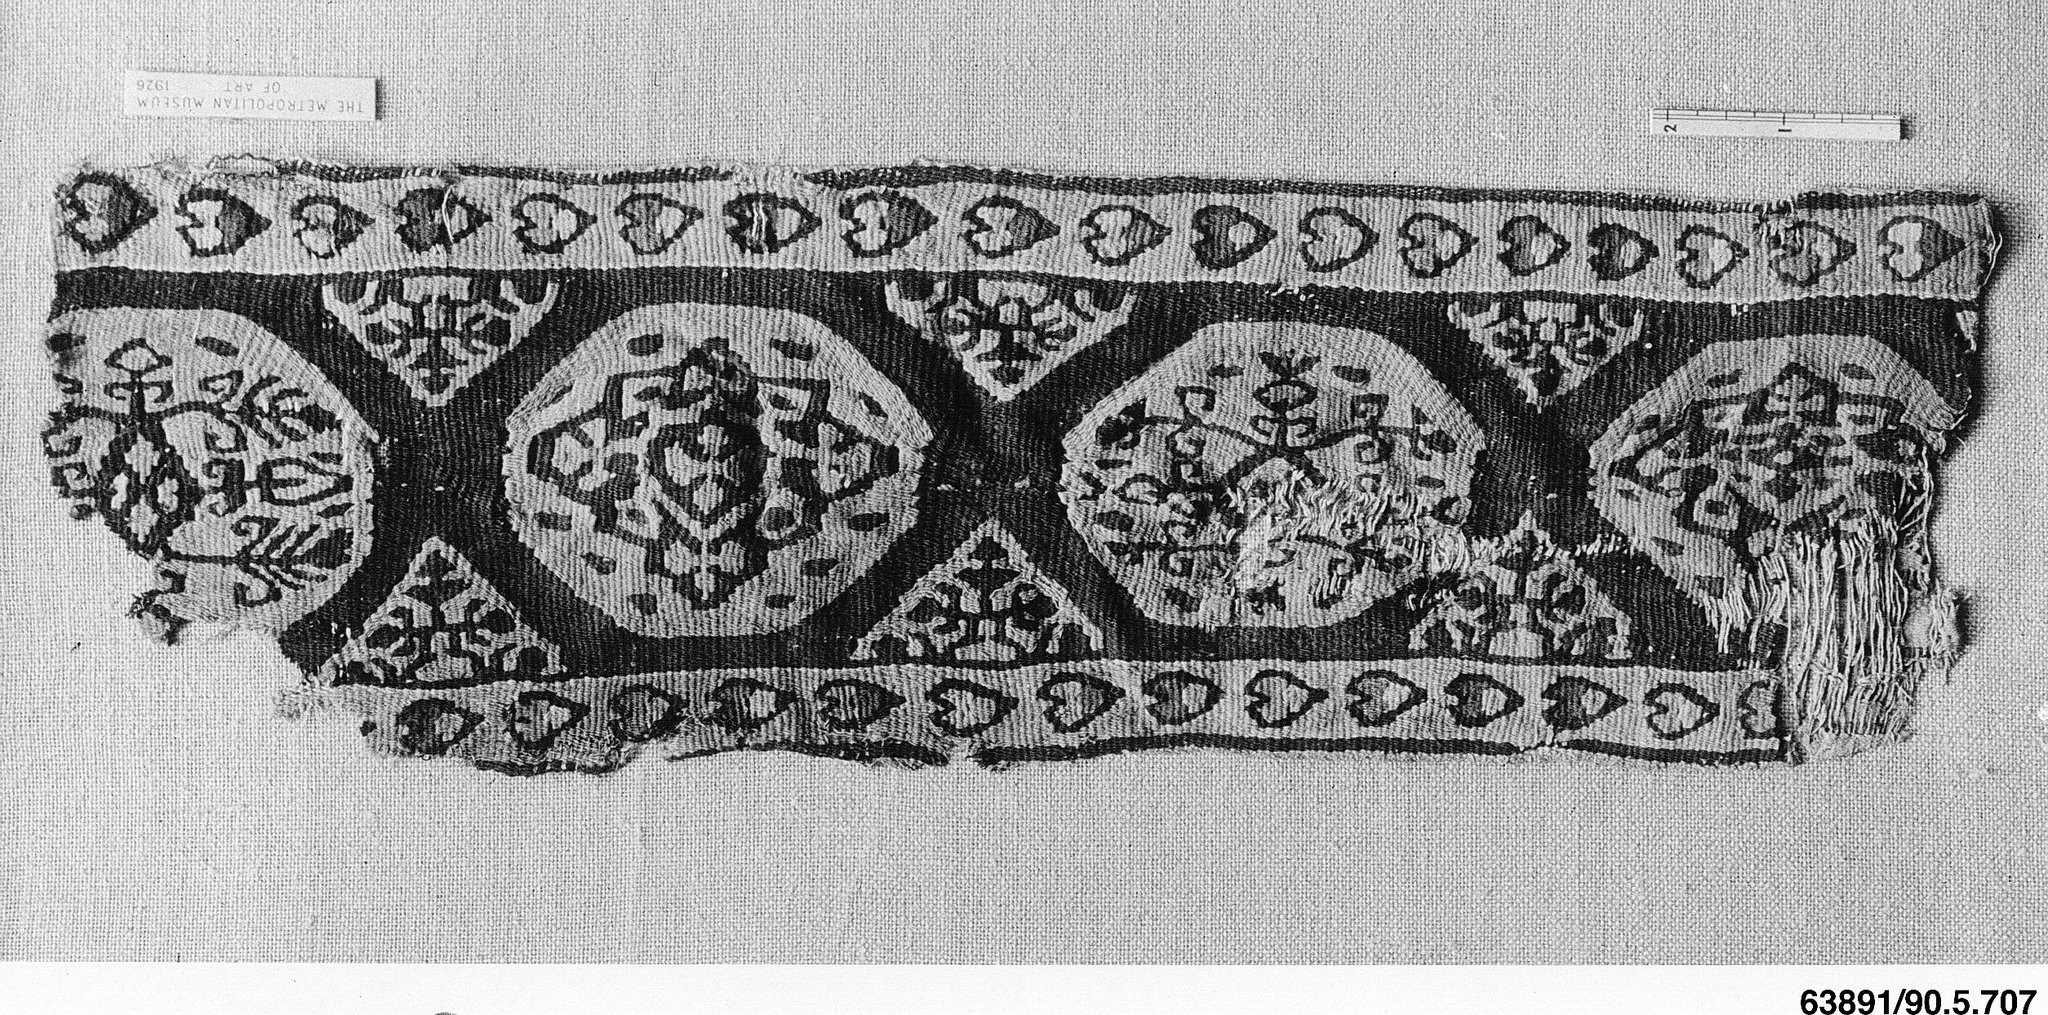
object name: textile fragment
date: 401-600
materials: linen, wool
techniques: weave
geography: egypt